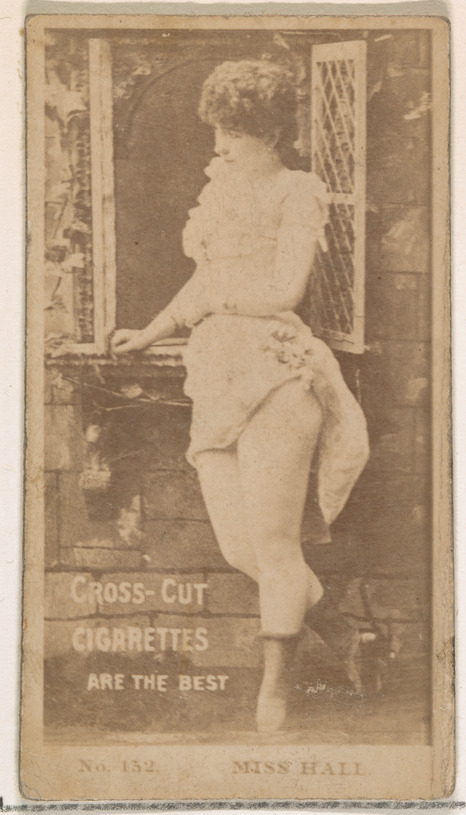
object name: print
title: Card Number 132, Miss Hall, from the Actors and Actresses series (N145-2) issued by Duke Sons & Co. to promote Cross Cut Cigarettes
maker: w. duke, sons & co.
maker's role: publisher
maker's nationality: american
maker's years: 1870-1920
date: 1880-1889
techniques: albumen silver print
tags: women,actresses